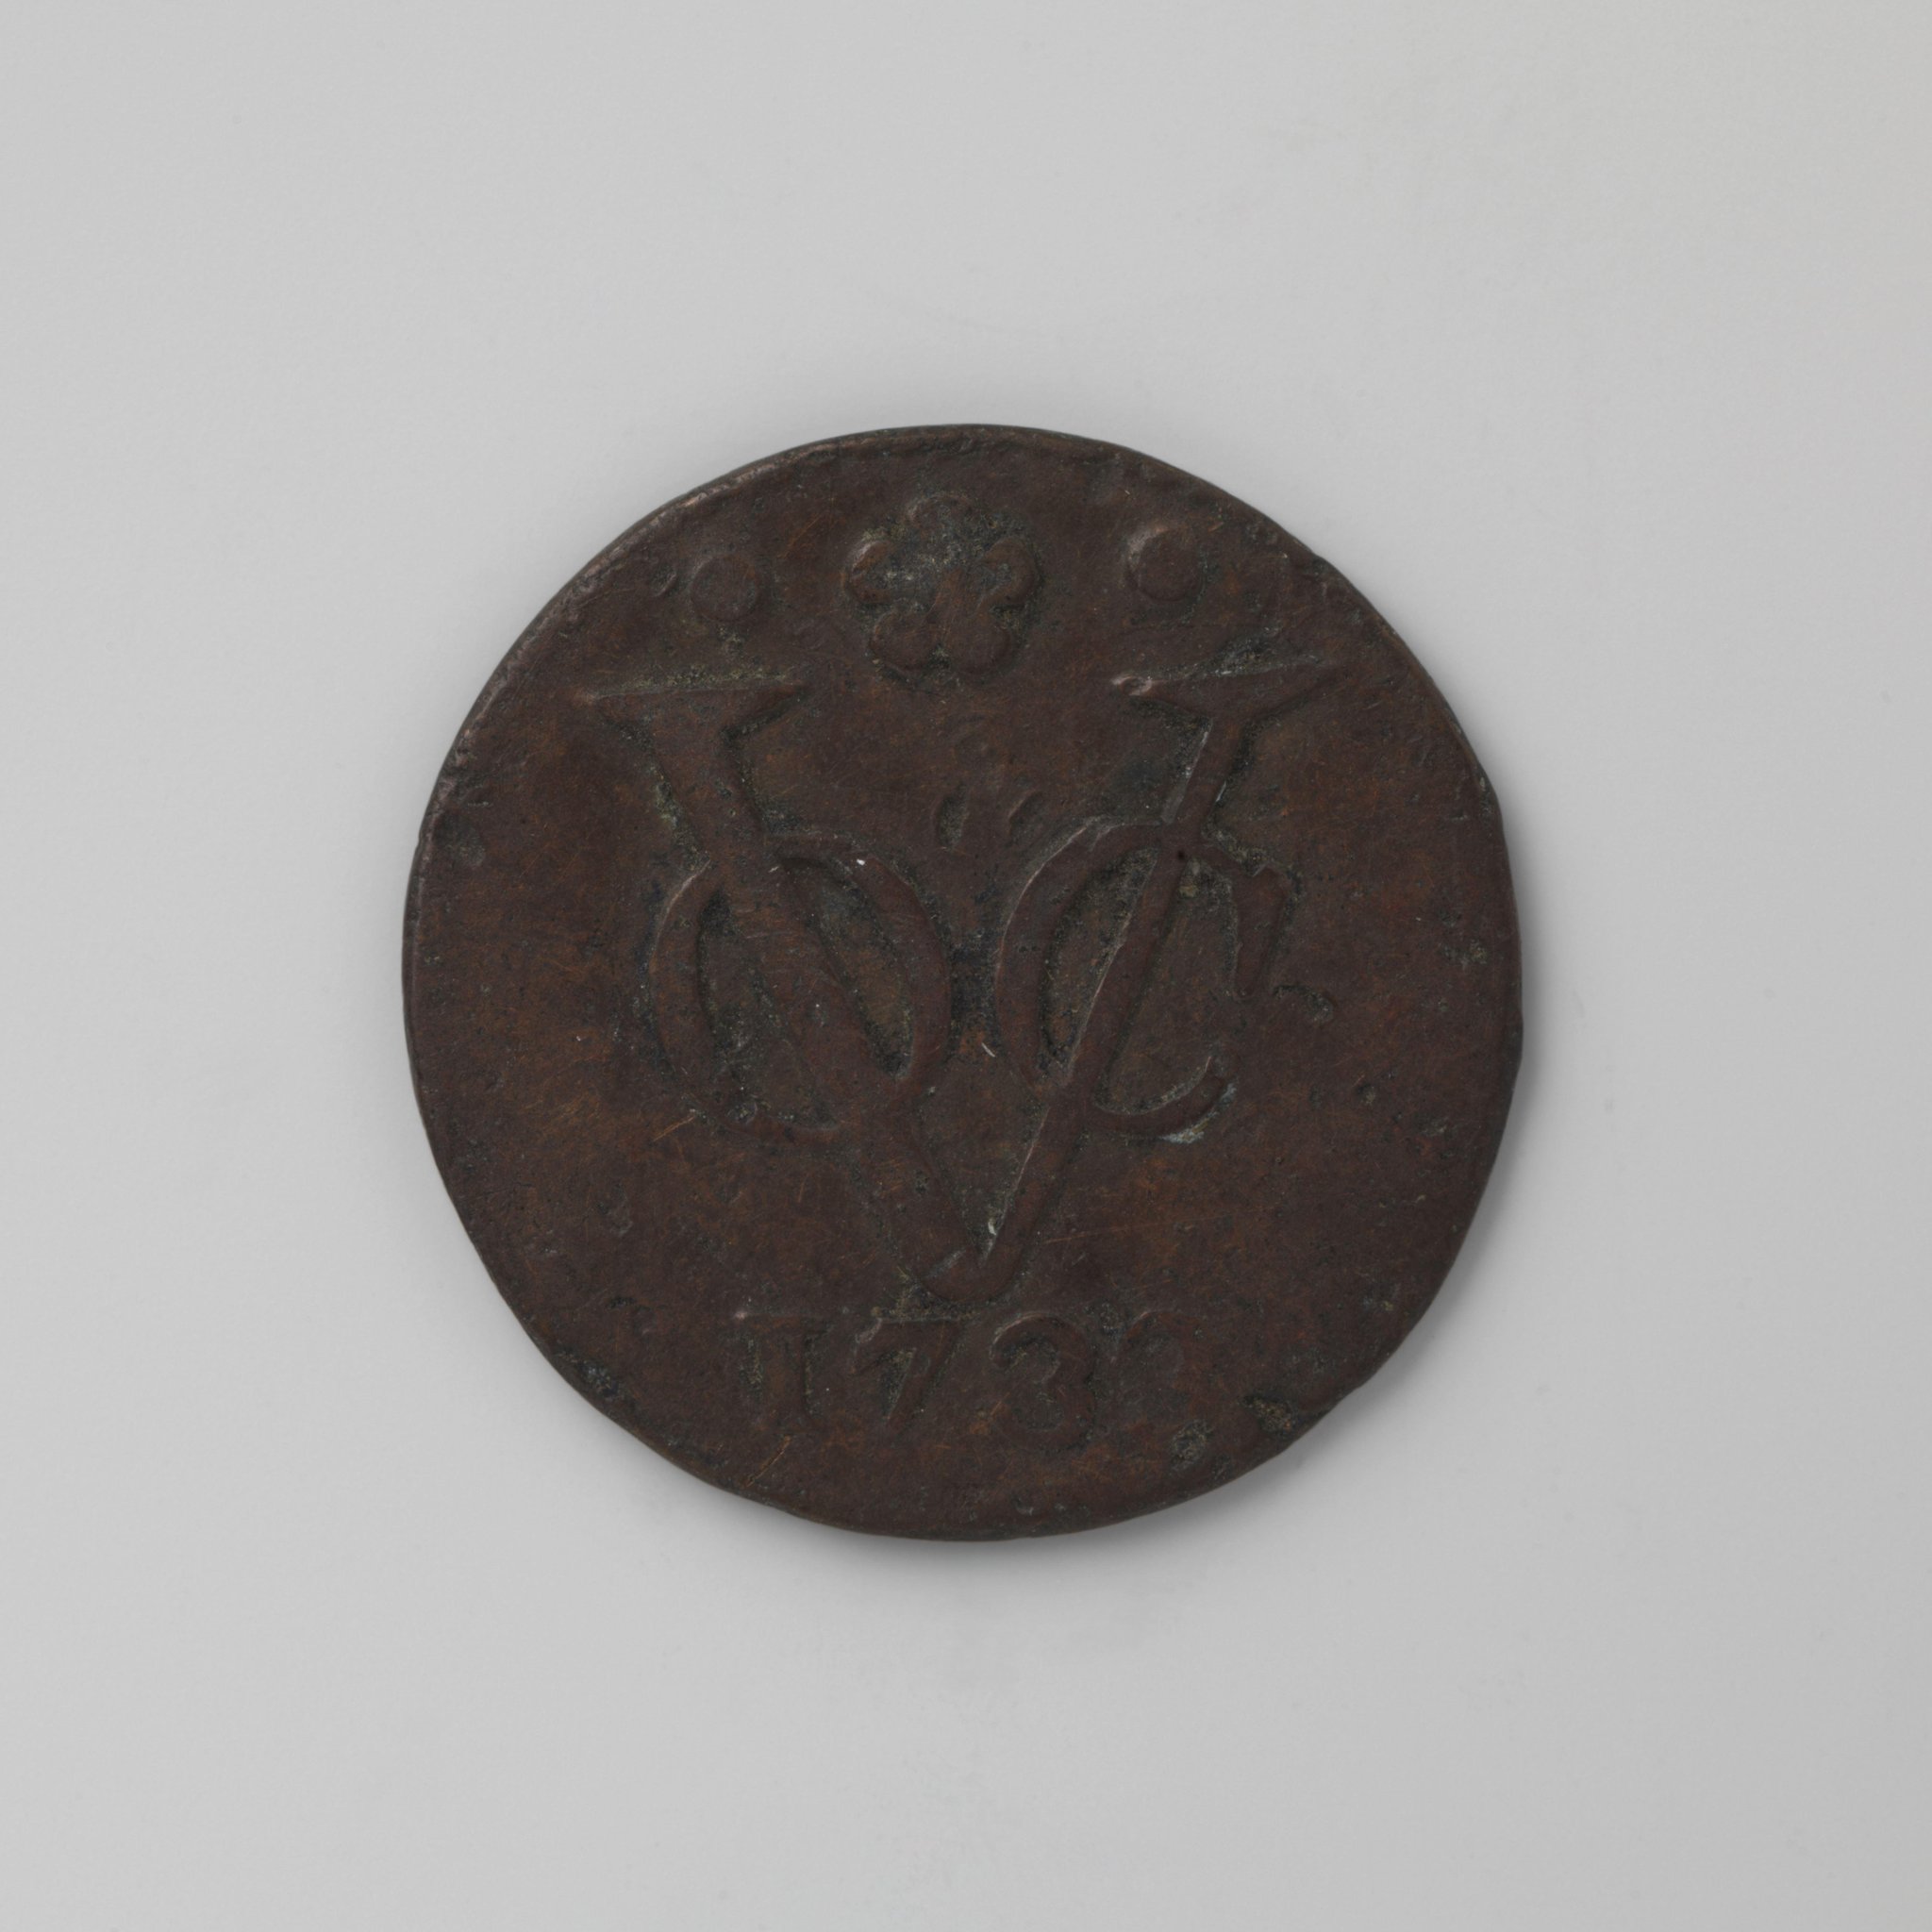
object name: coin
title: Duit van de VOC uit Holland, 1733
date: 1733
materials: copper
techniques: striking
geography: dordrecht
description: Koperen munt. Voorzijde: gekroond wapenschild van Holland. Keerzijde: monogram van de VOC, waarboven muntteken en waaronder jaartal. Gladde rand.